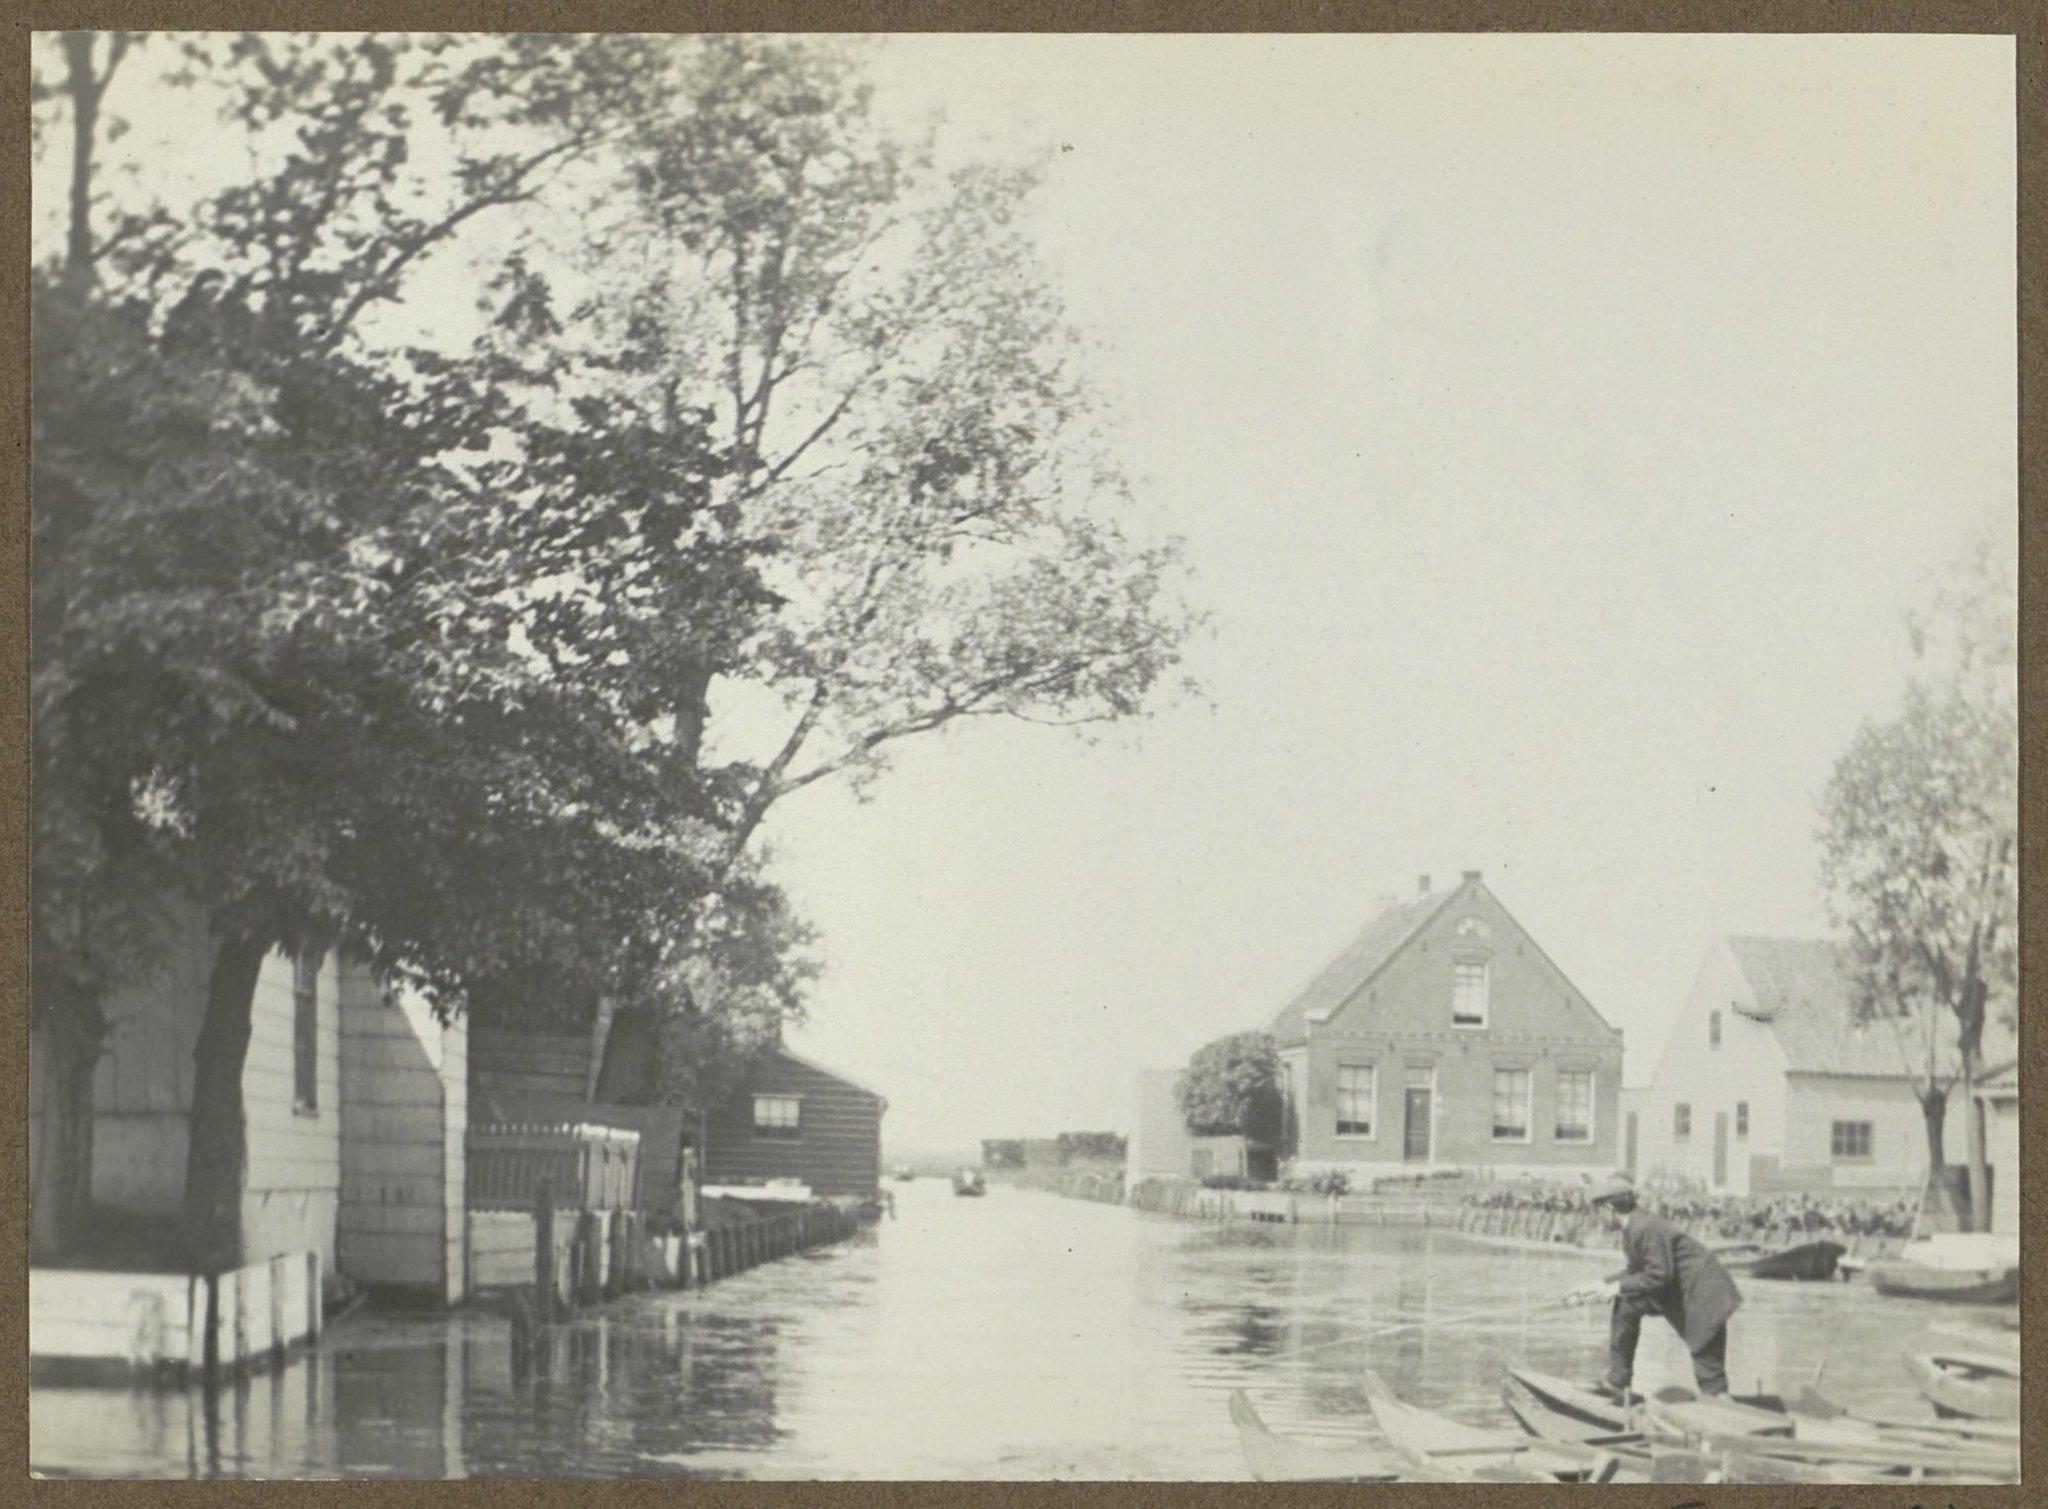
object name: photograph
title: Huizen aan de Krommert in Amsterdam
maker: Anonymous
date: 1910-1930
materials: paper, photographic support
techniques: gelatin silver print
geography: amsterdam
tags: small canal, ditch, amsterdam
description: De Krommert was een water in Amsterdam dat liep van de Admiralengracht naar de Kostverlorenvaart, evenwijdig aan de Admiraal de Ruijterweg ten oosten van de splitsing met de Jan Evertsenstraat.